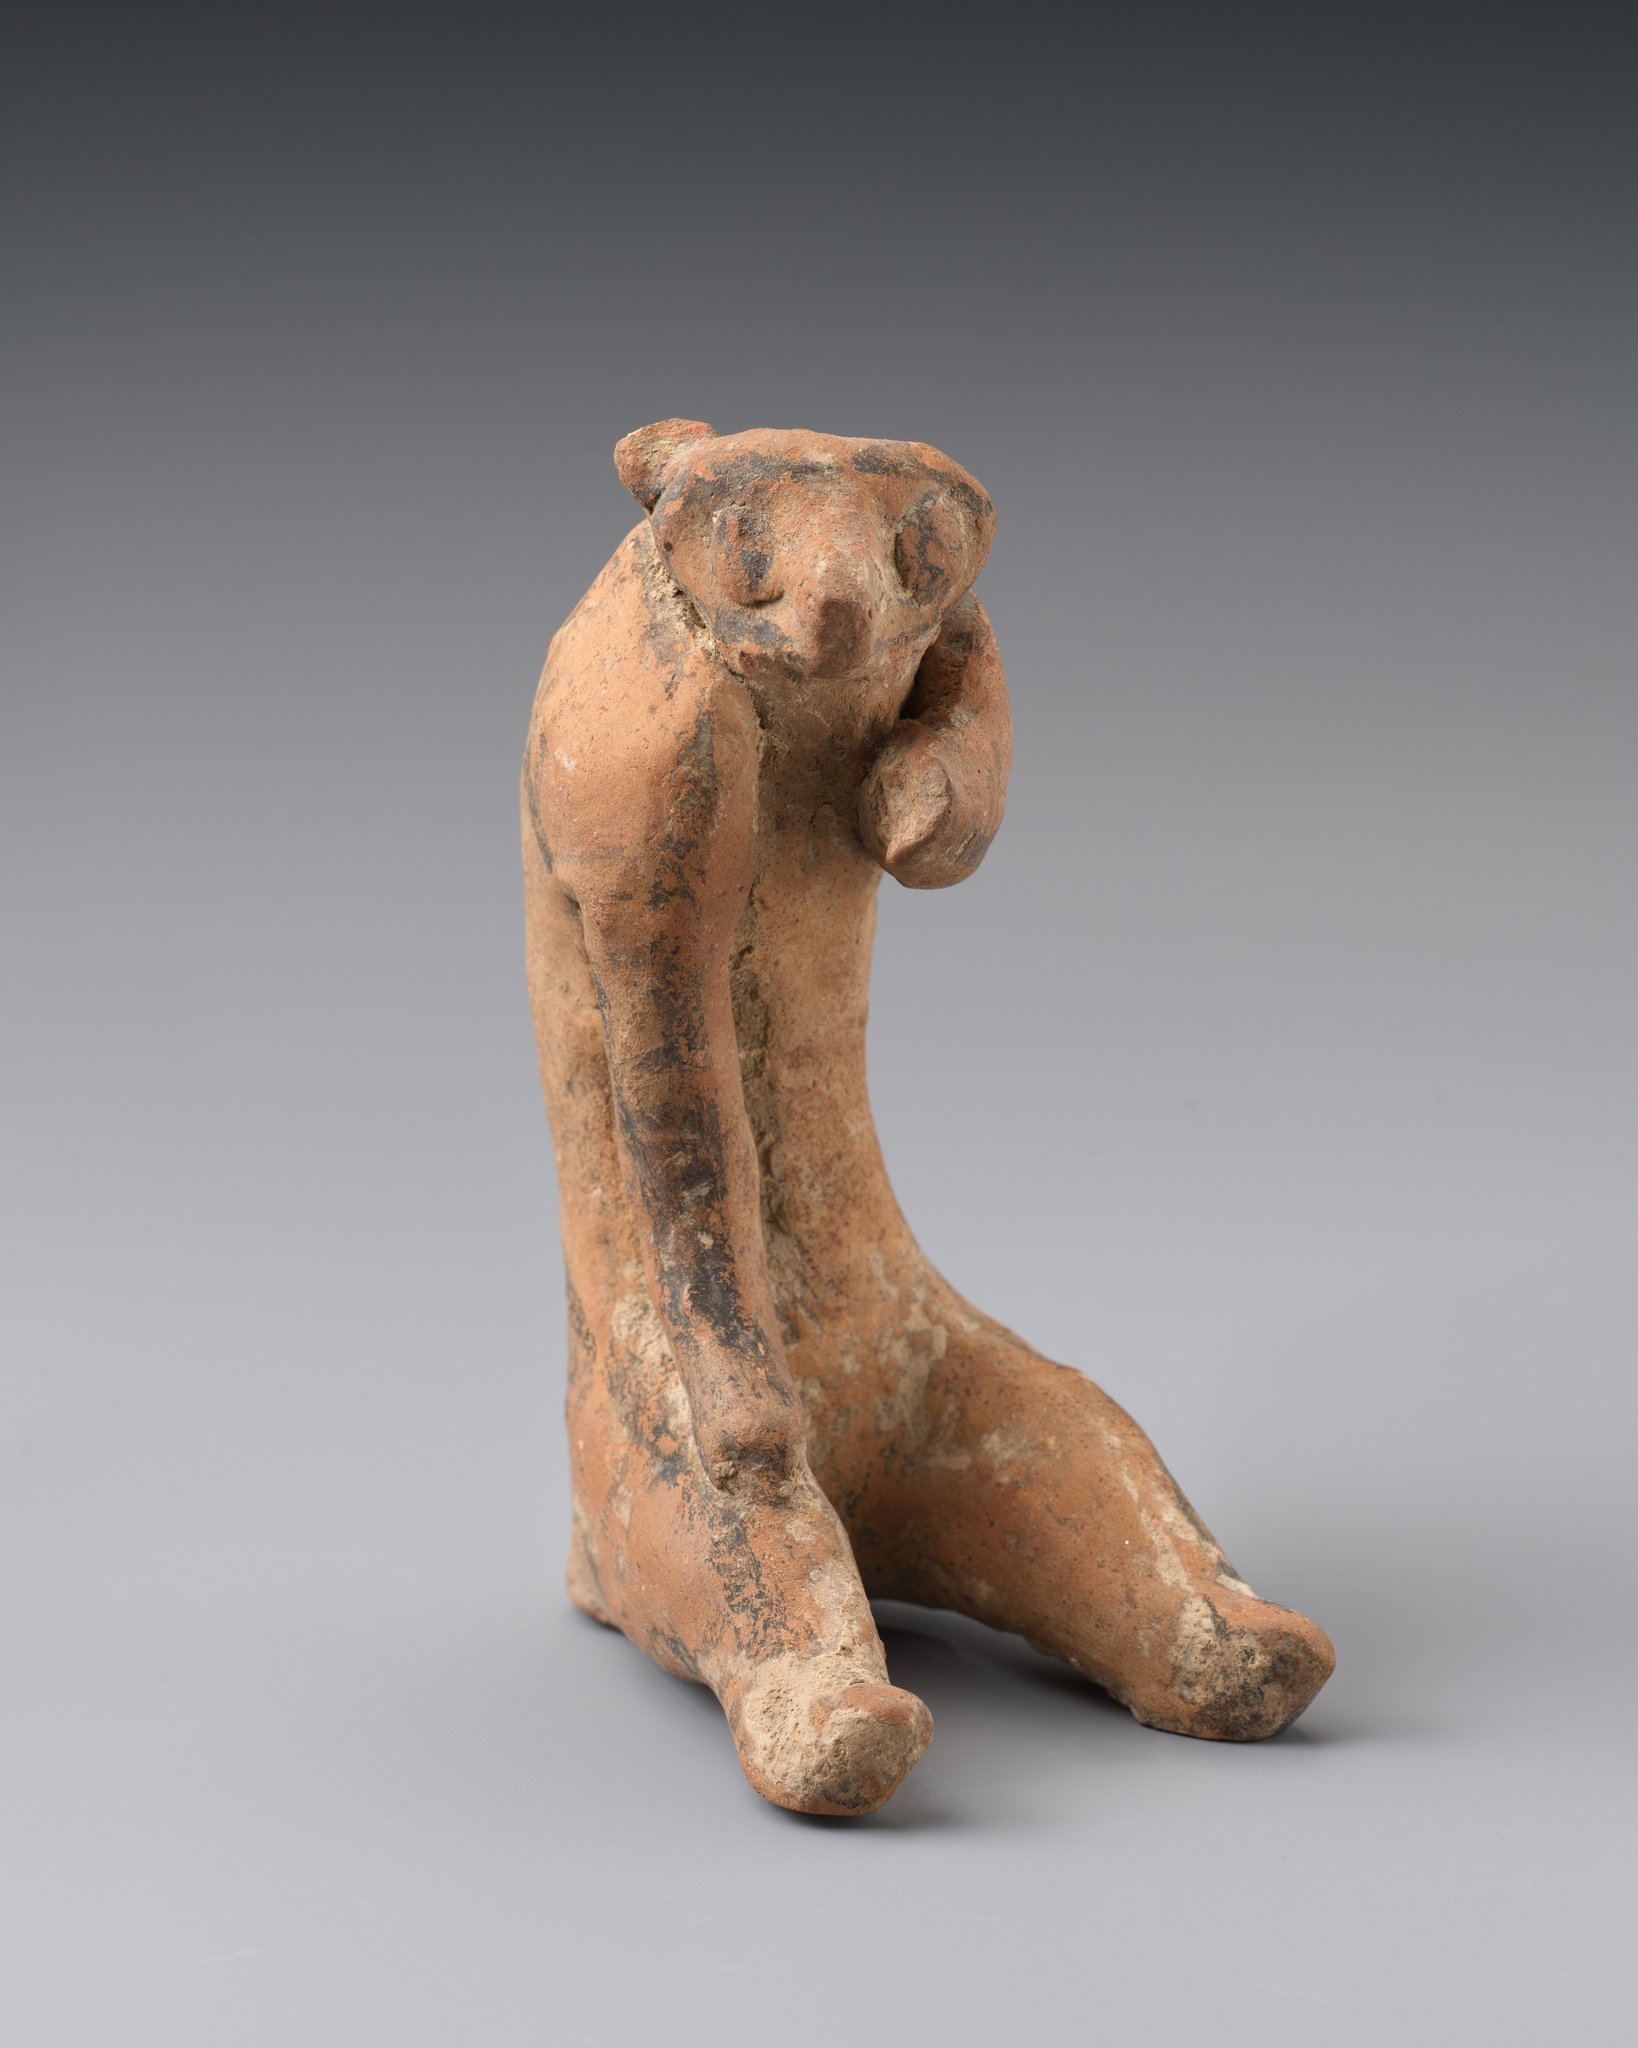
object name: statuette of a monkey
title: Terracotta statuette of a monkey or bear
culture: cypriot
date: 600-480 BCE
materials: terracotta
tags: bears,monkeys